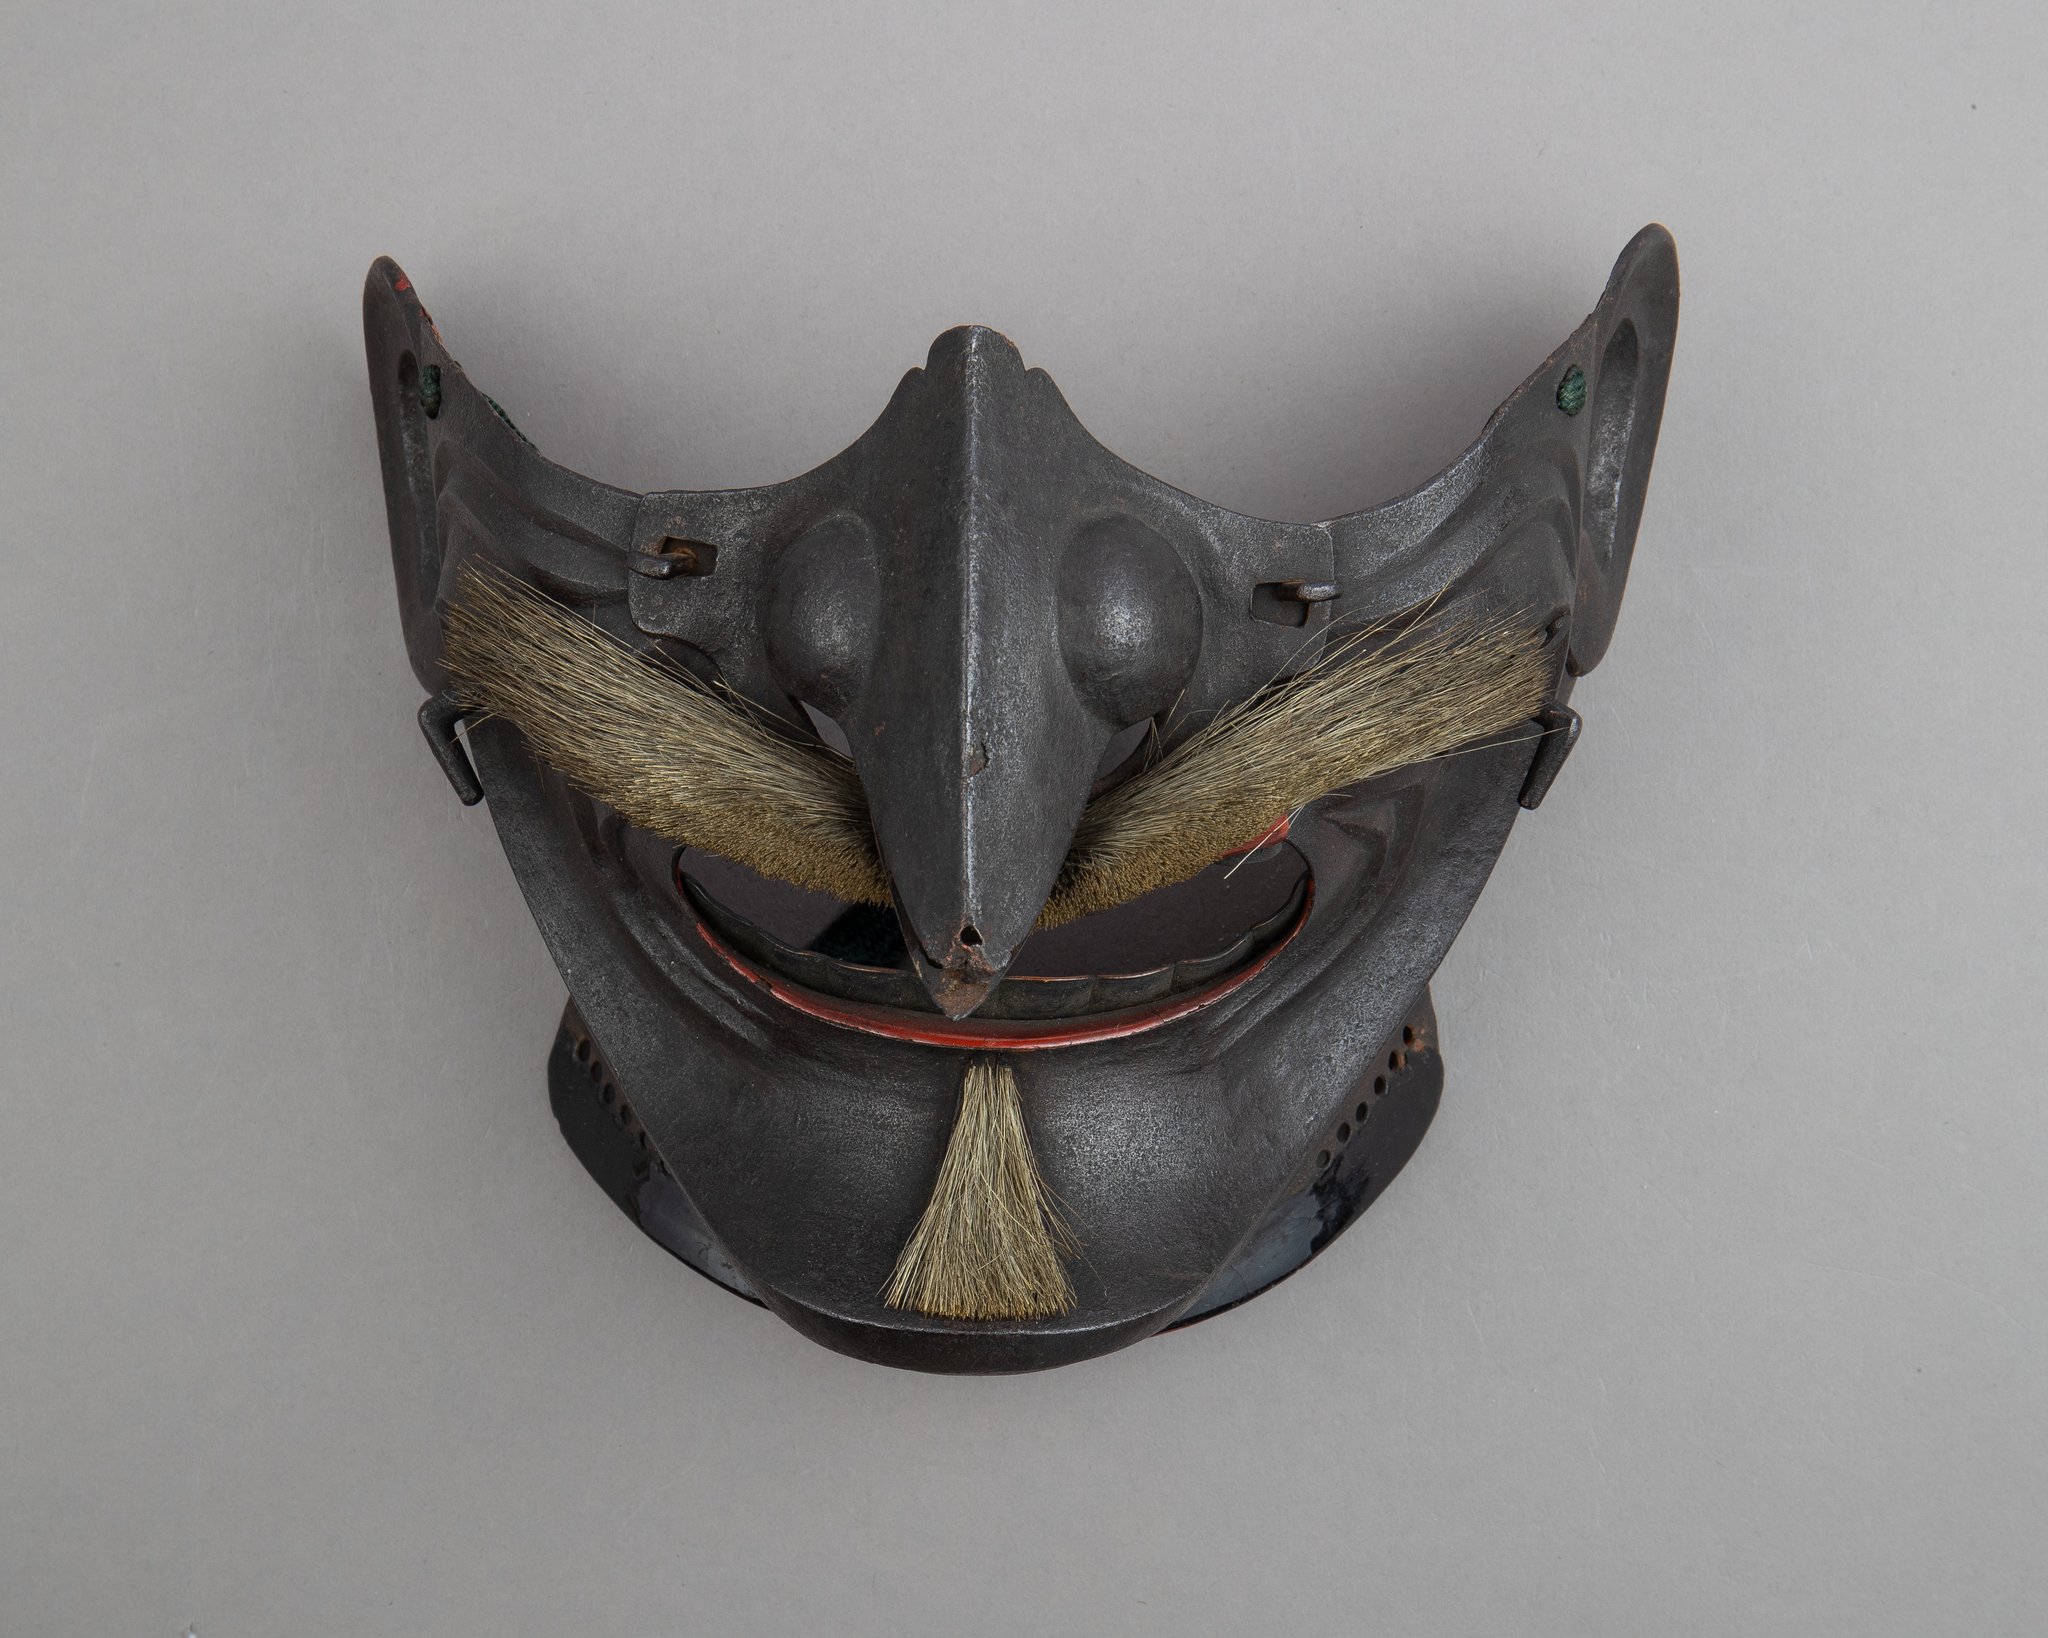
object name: half mask menpō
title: Half Mask (Menpō)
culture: japanese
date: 1615-1868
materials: hair, iron, lacquer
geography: japan